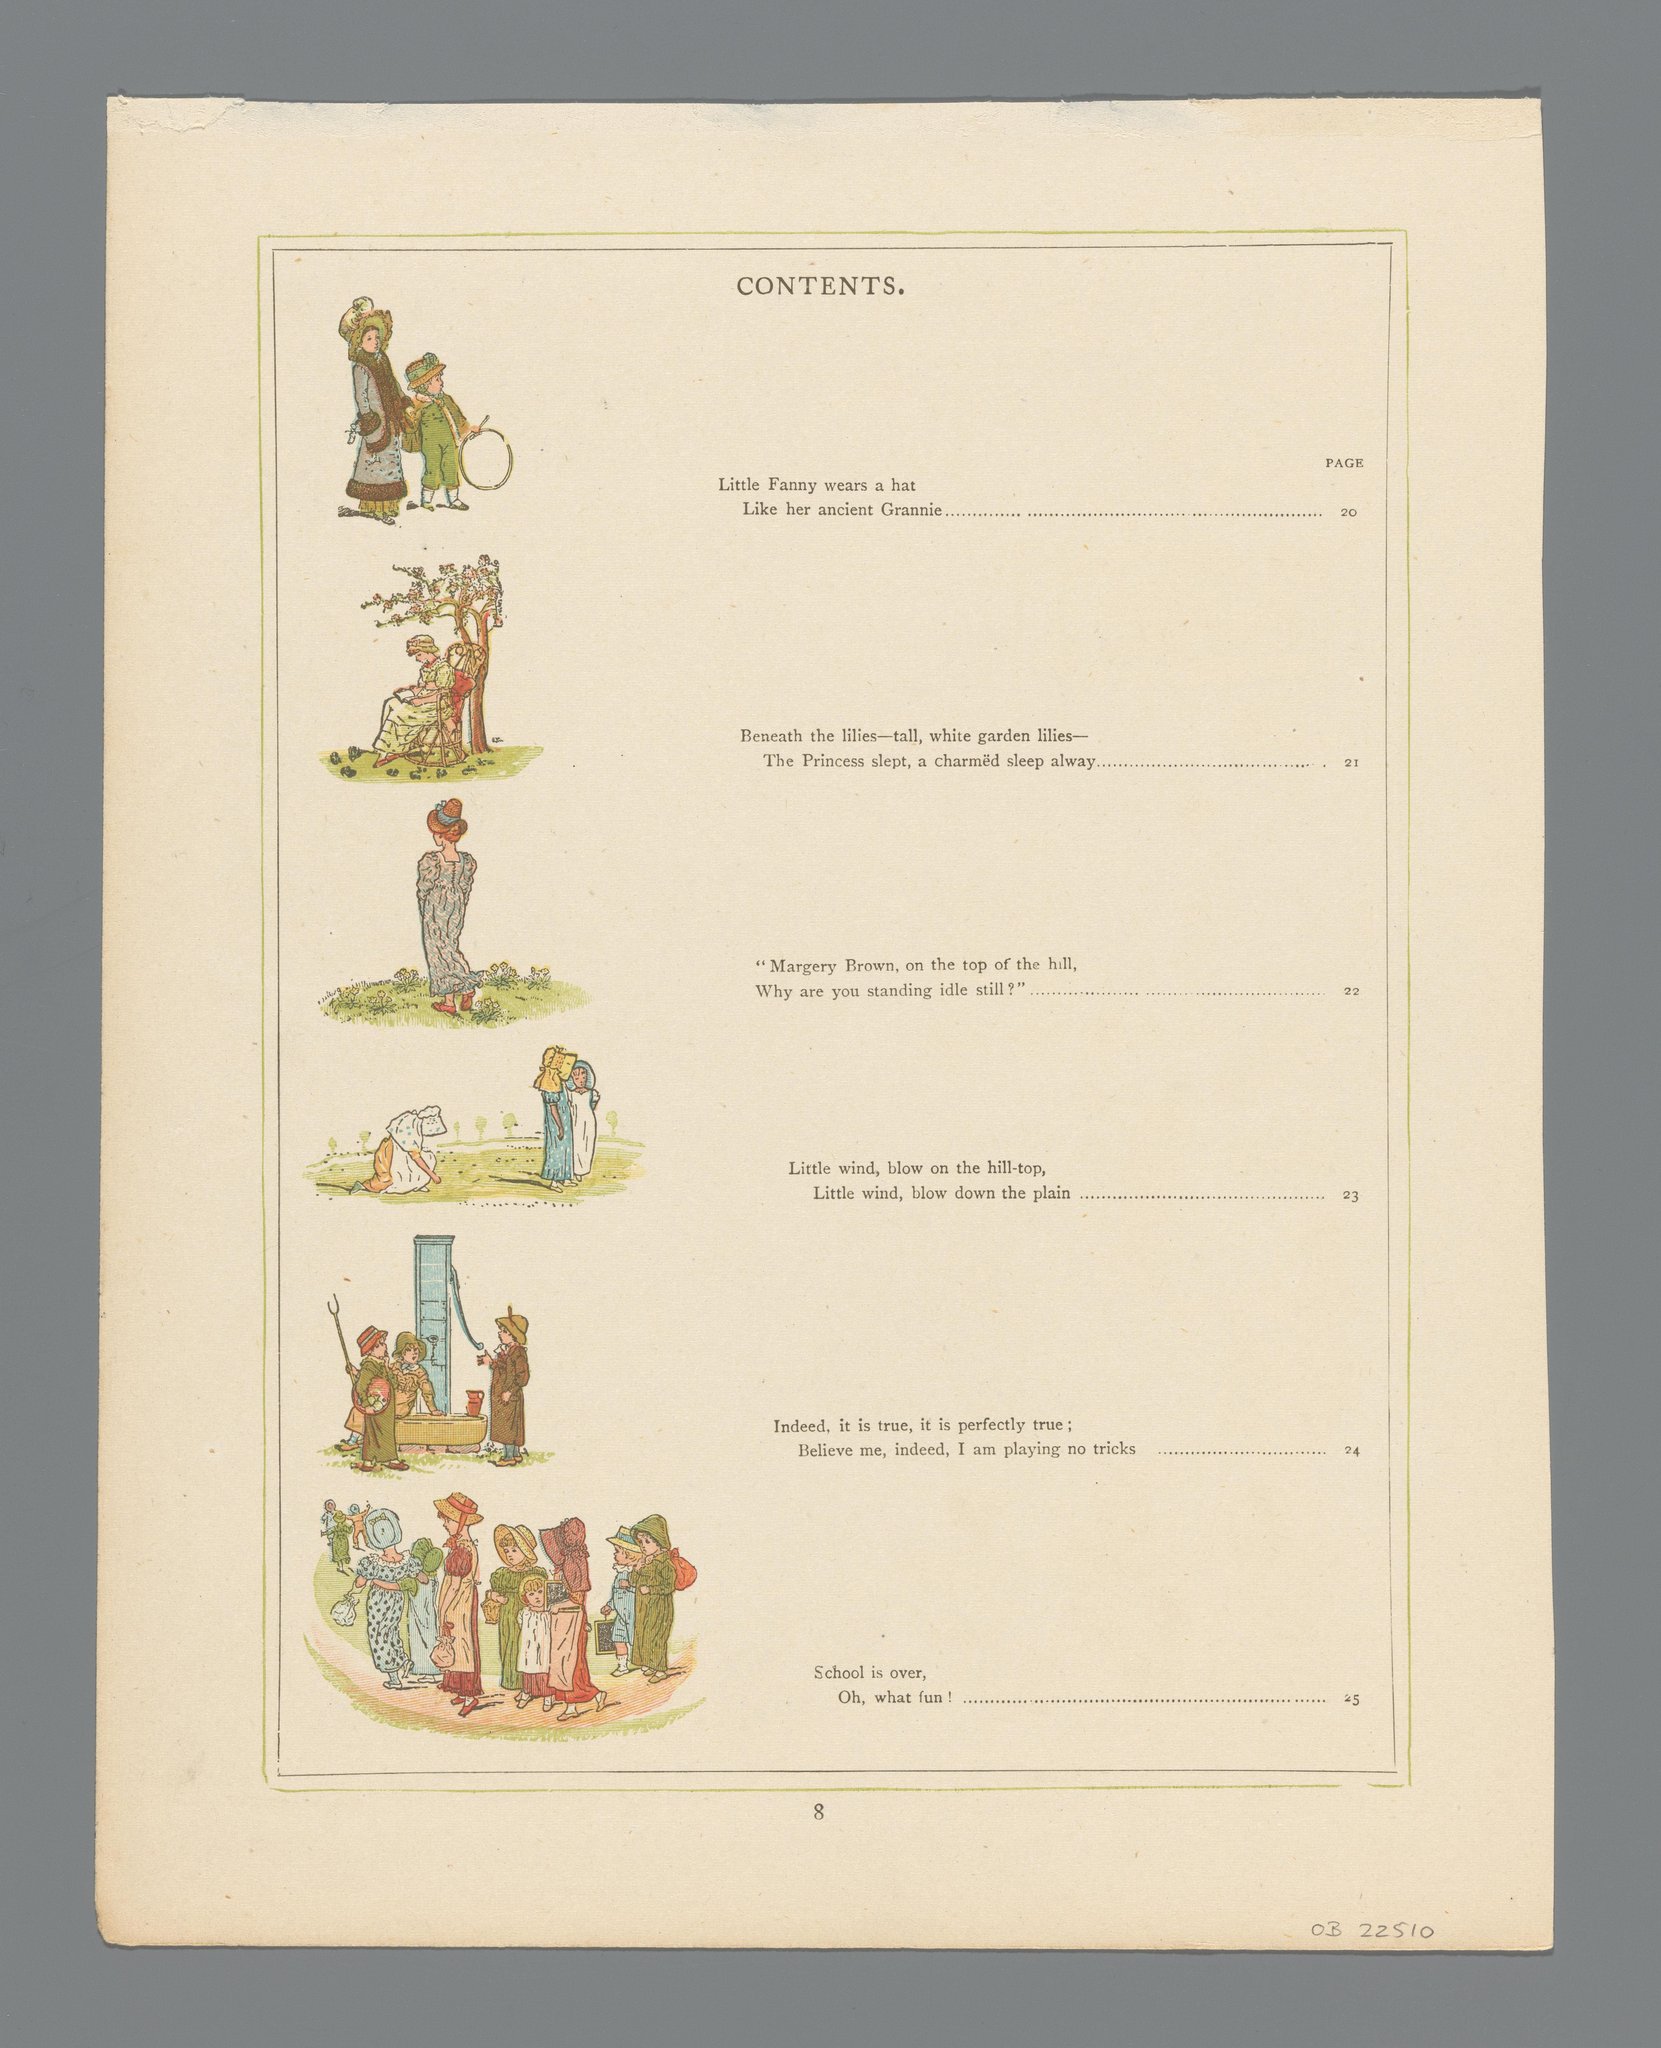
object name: table of content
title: Zes genrevoorstellingen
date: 1878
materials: paper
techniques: wood engraving, letterpress printing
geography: london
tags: child, family life at home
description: Prent uit: Greenaway, Kate. Under the window, pictures & rhymes for children. Londen: George Routledge & Sons, 1878, p. 8.